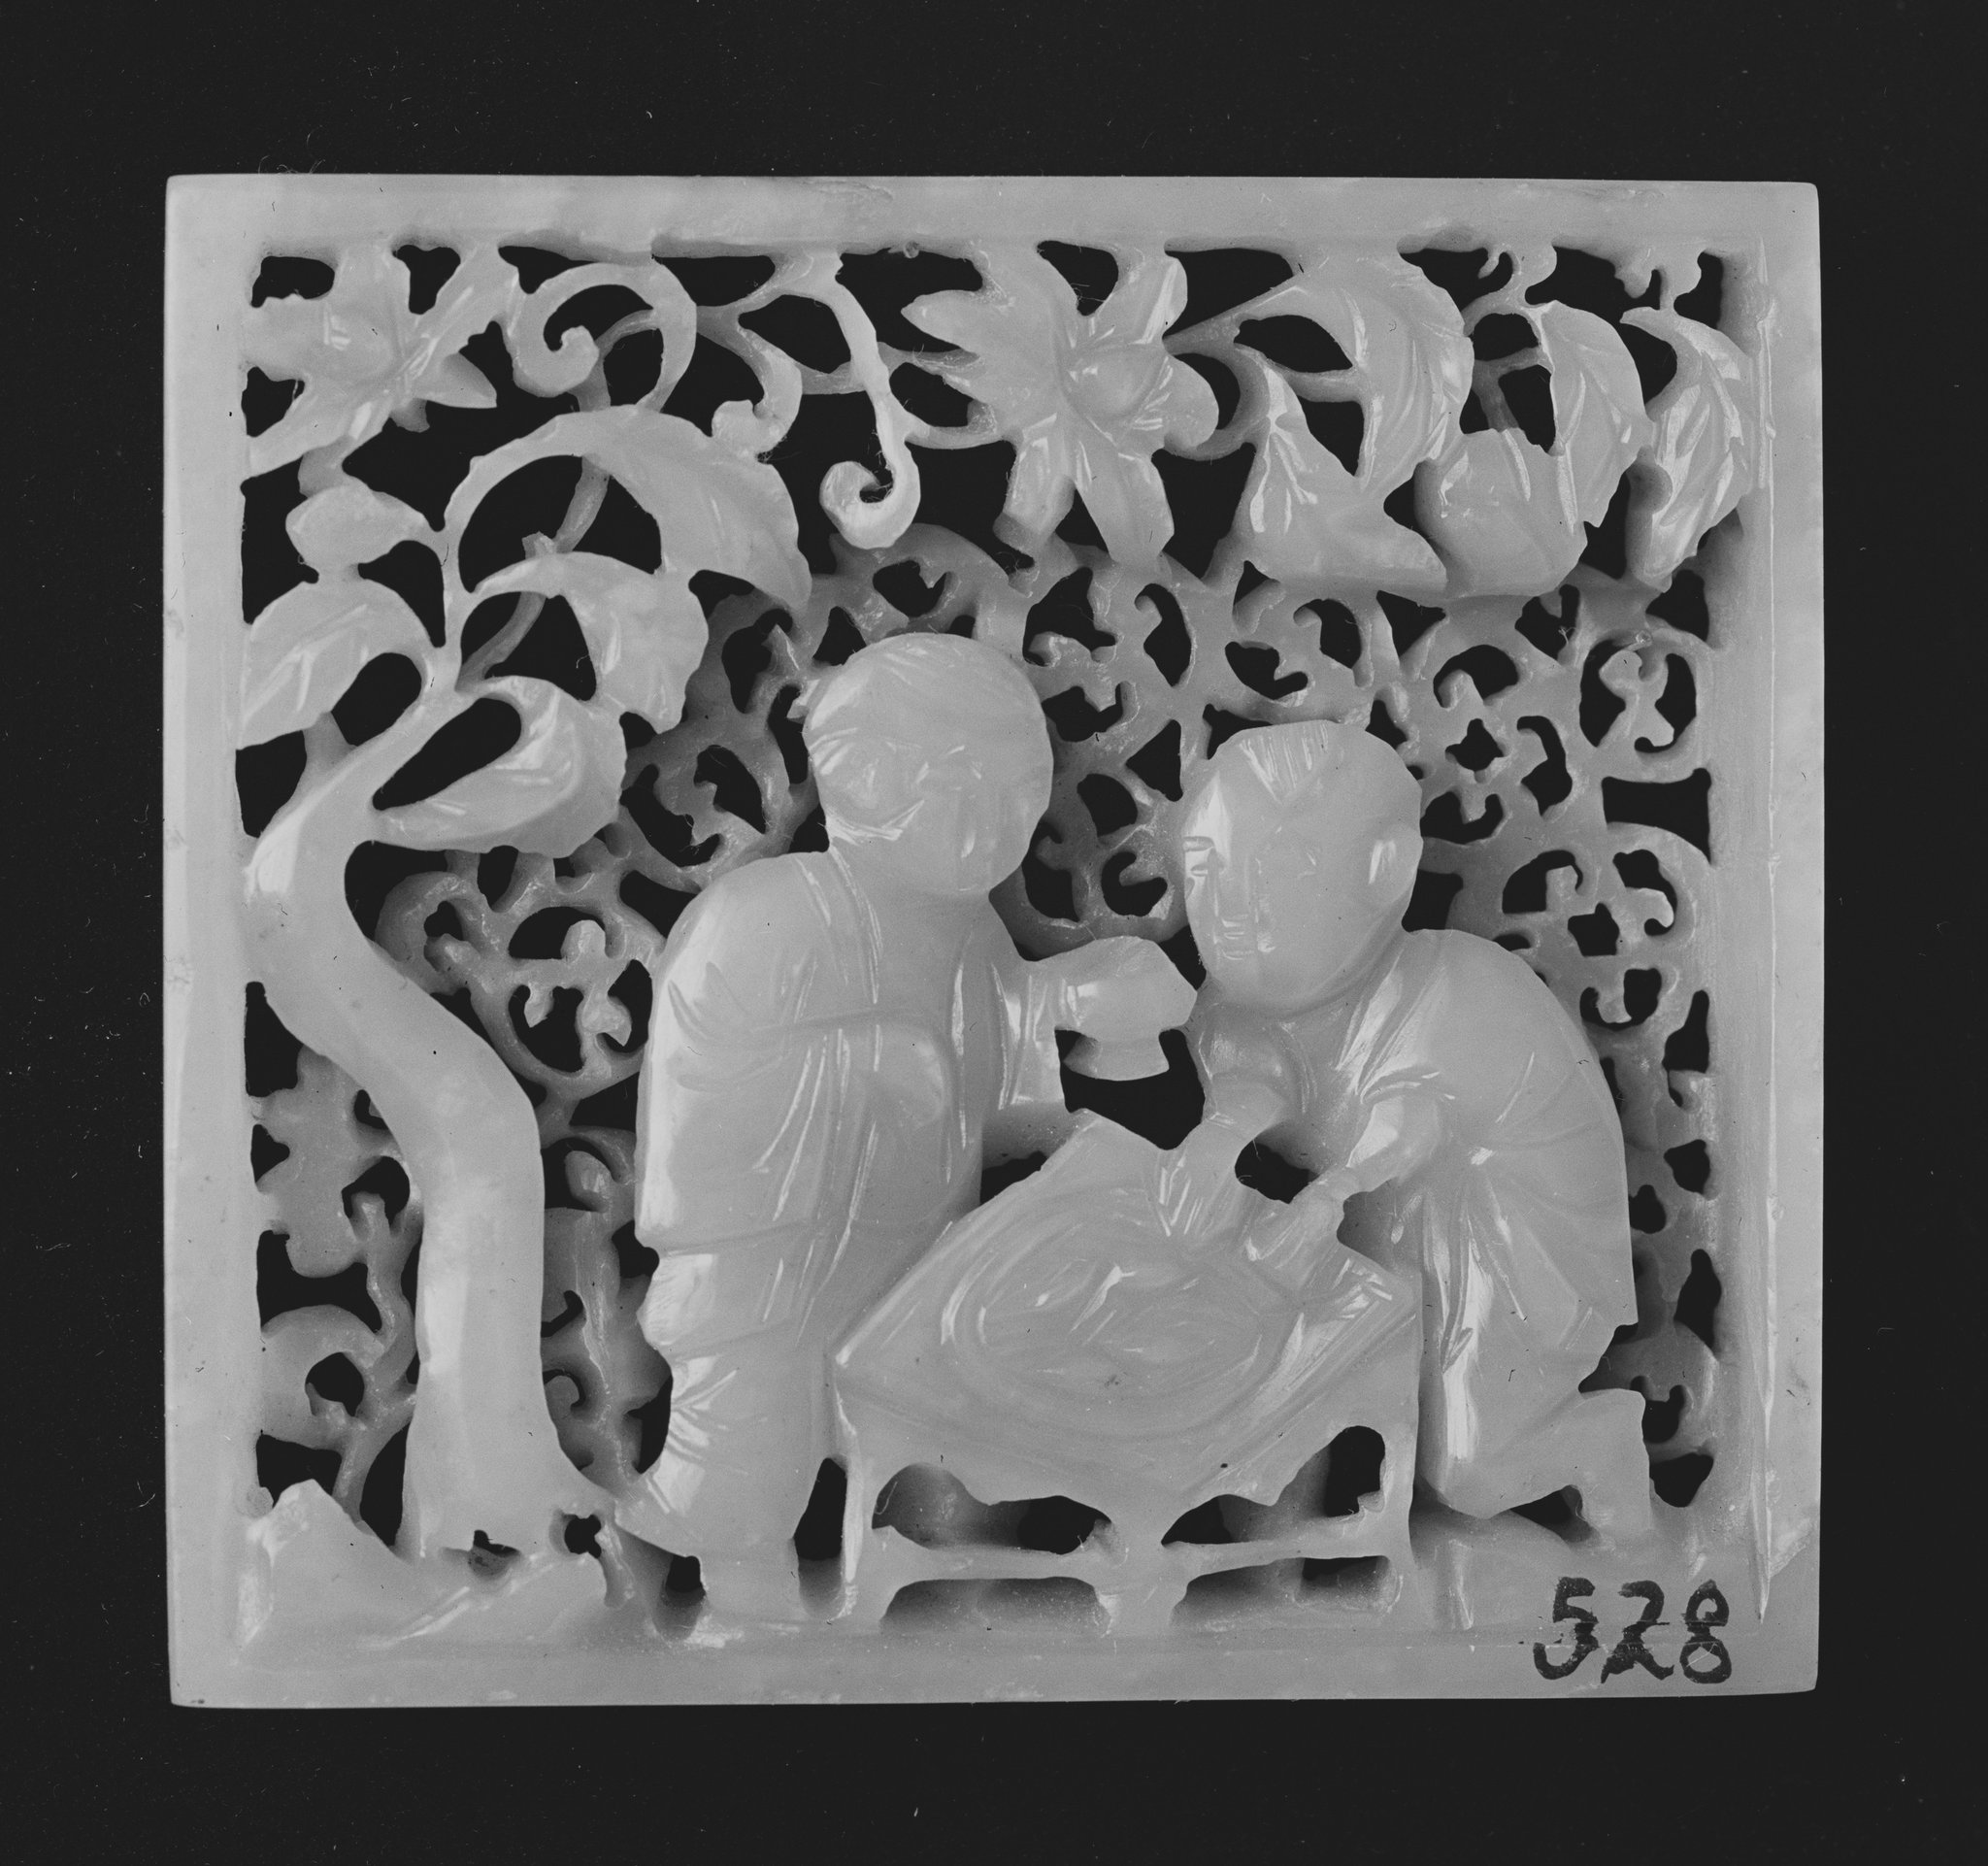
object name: plaque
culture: chinese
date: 1736-1795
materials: jade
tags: human figures,flowers,trees